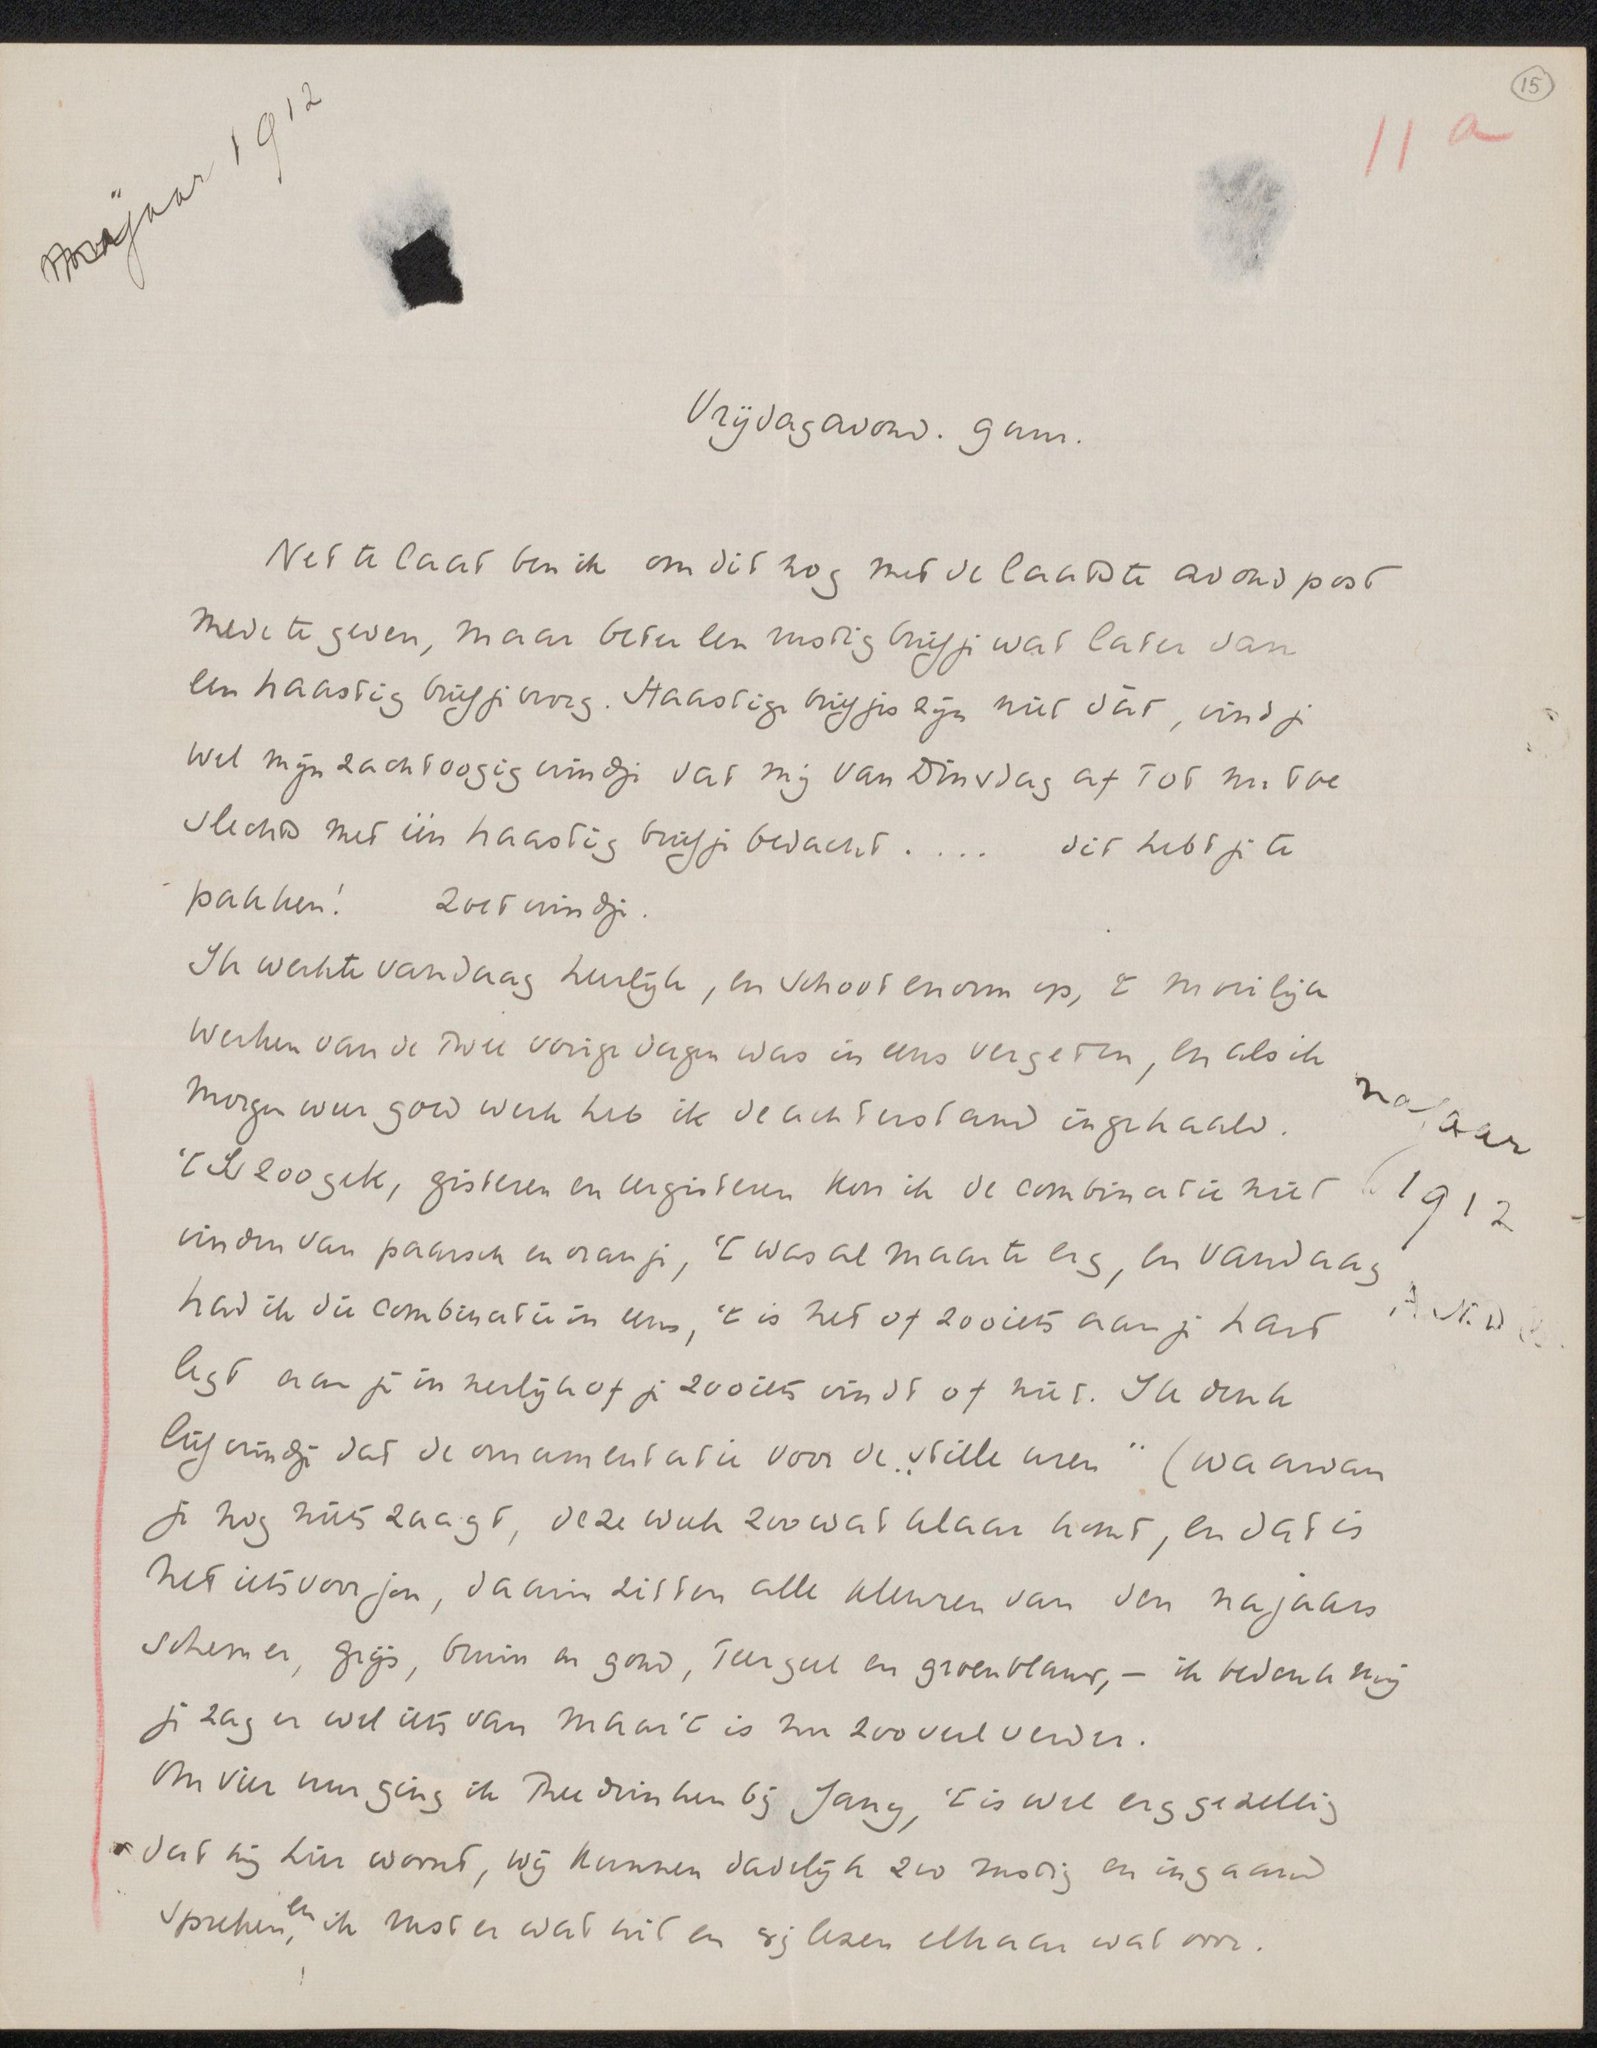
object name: letter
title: Brief aan Ina van Eibergen Santhagens-Waller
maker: richard nicolaüs roland holst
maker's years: 1868-1938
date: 1878-1938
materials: ink, paper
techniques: pen, writing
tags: haarlem, amsterdam, print maker, ina van eibergen santhagens-waller, passions, emotions, affections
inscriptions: collector's mark: ‘RPK’